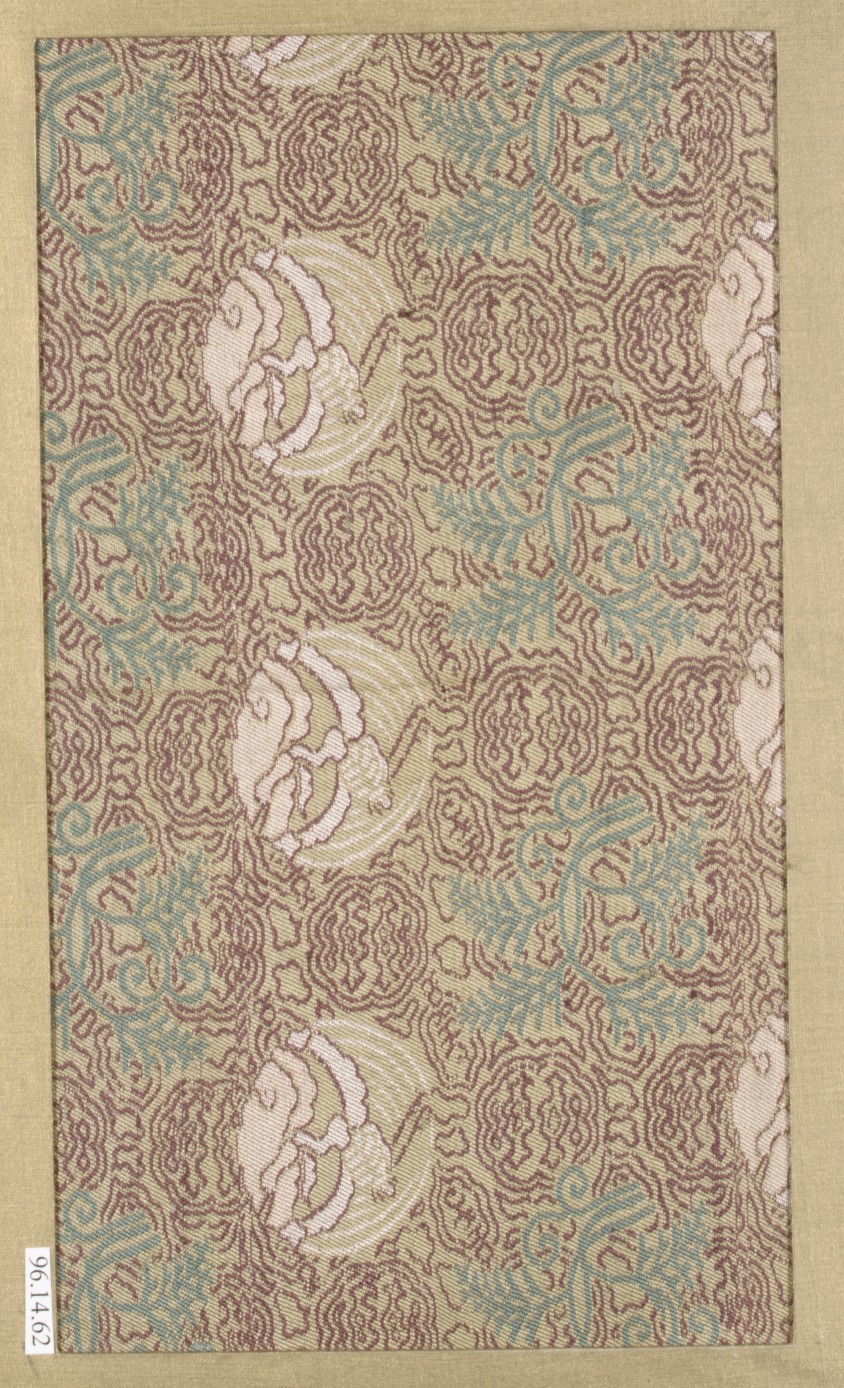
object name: piece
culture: japanese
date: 1701-1800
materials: silk